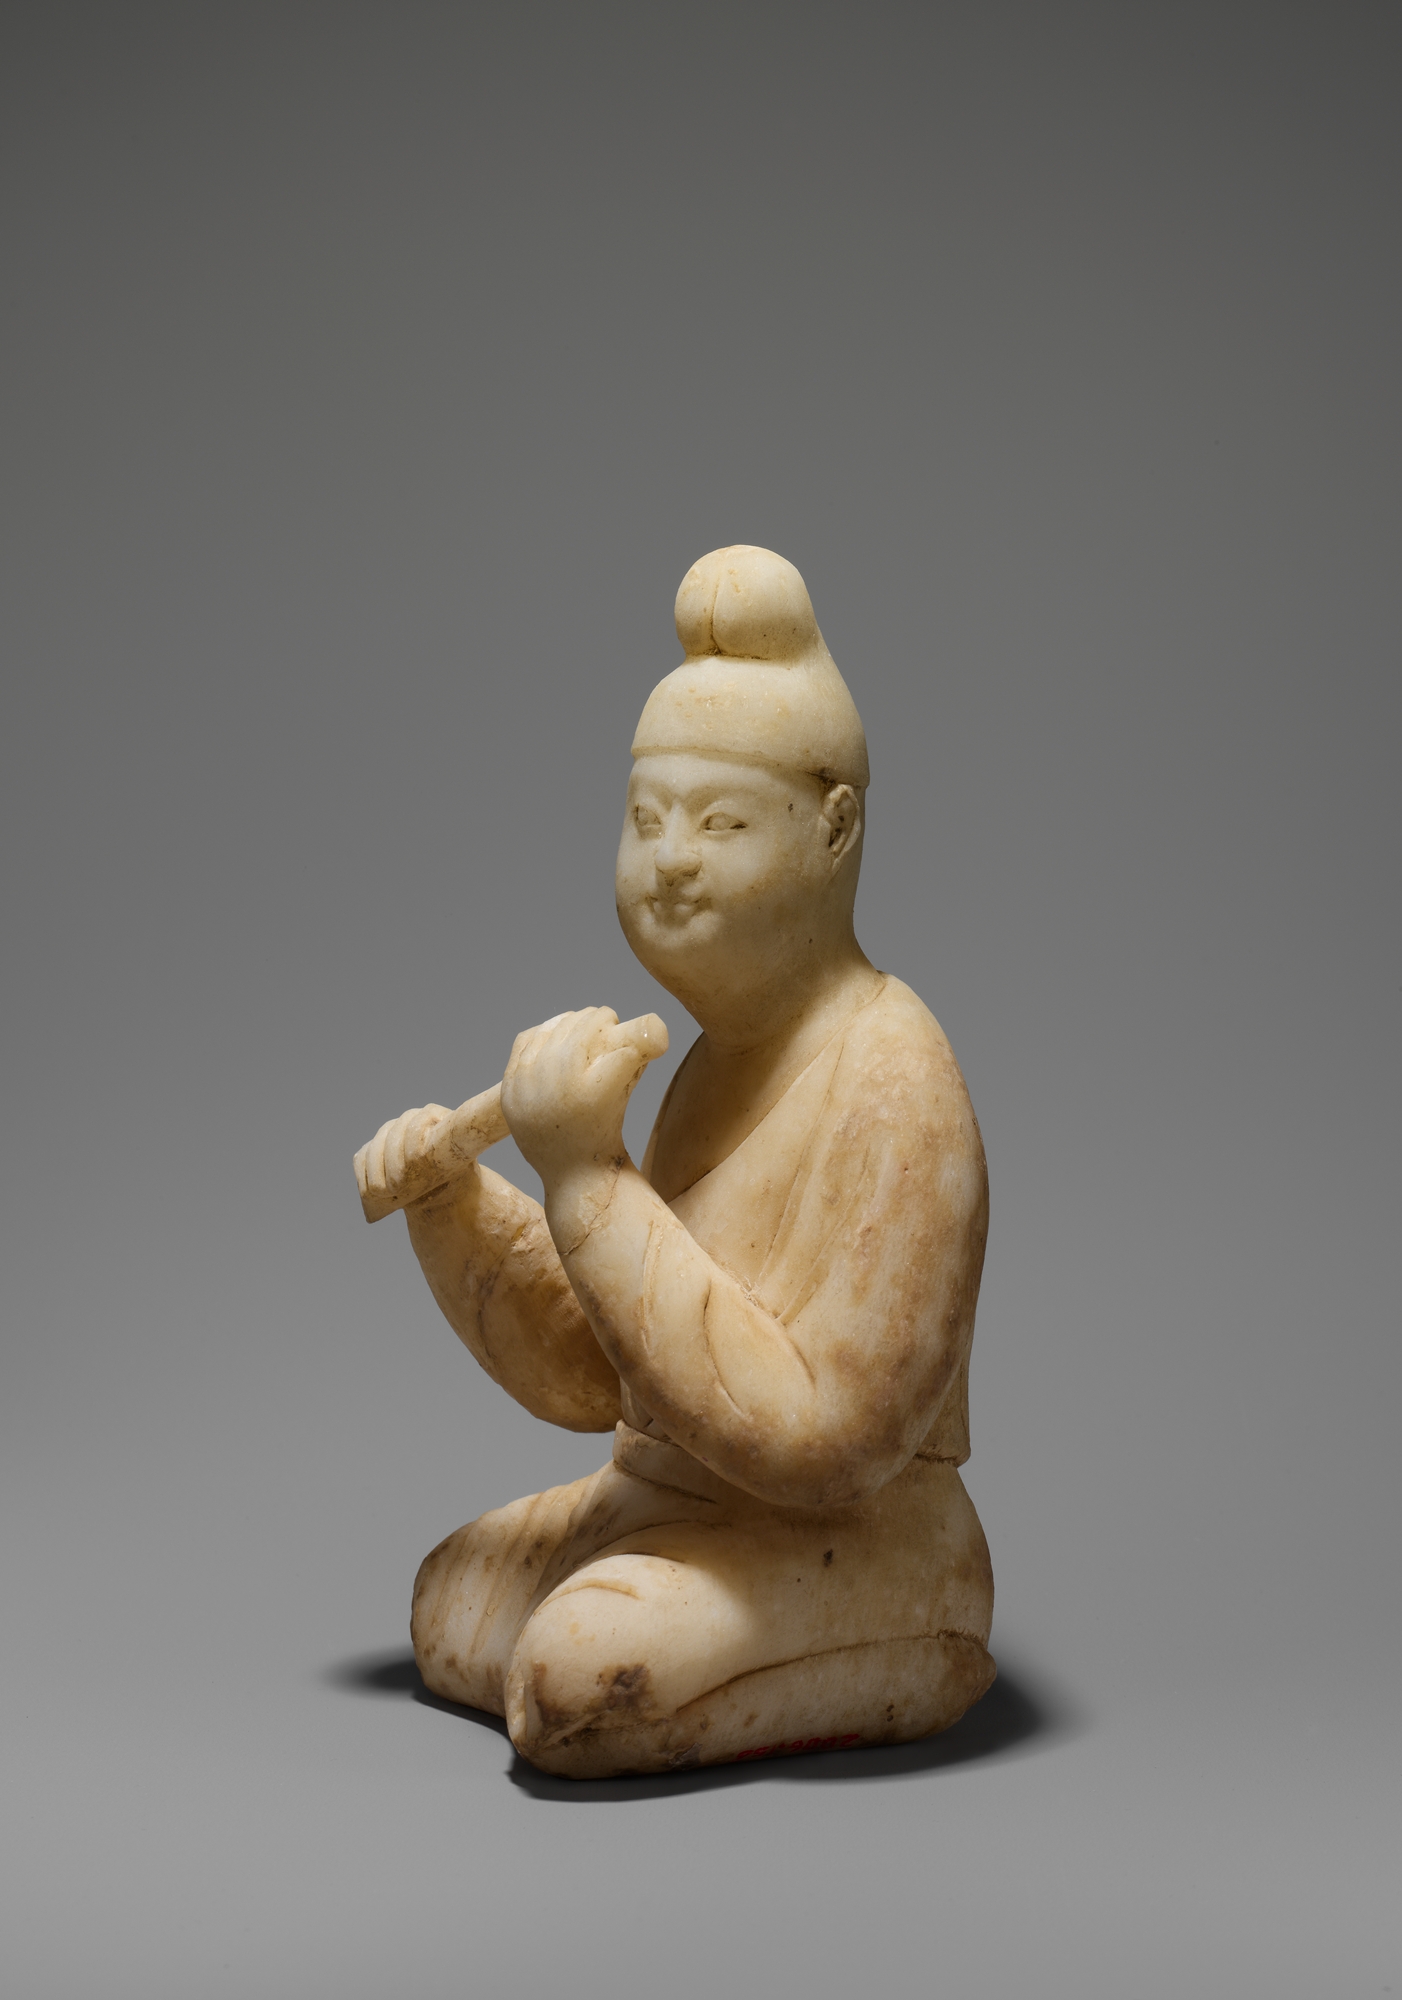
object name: figure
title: Seated Musician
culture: chinese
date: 618-907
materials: marble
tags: men,flutes,musicians